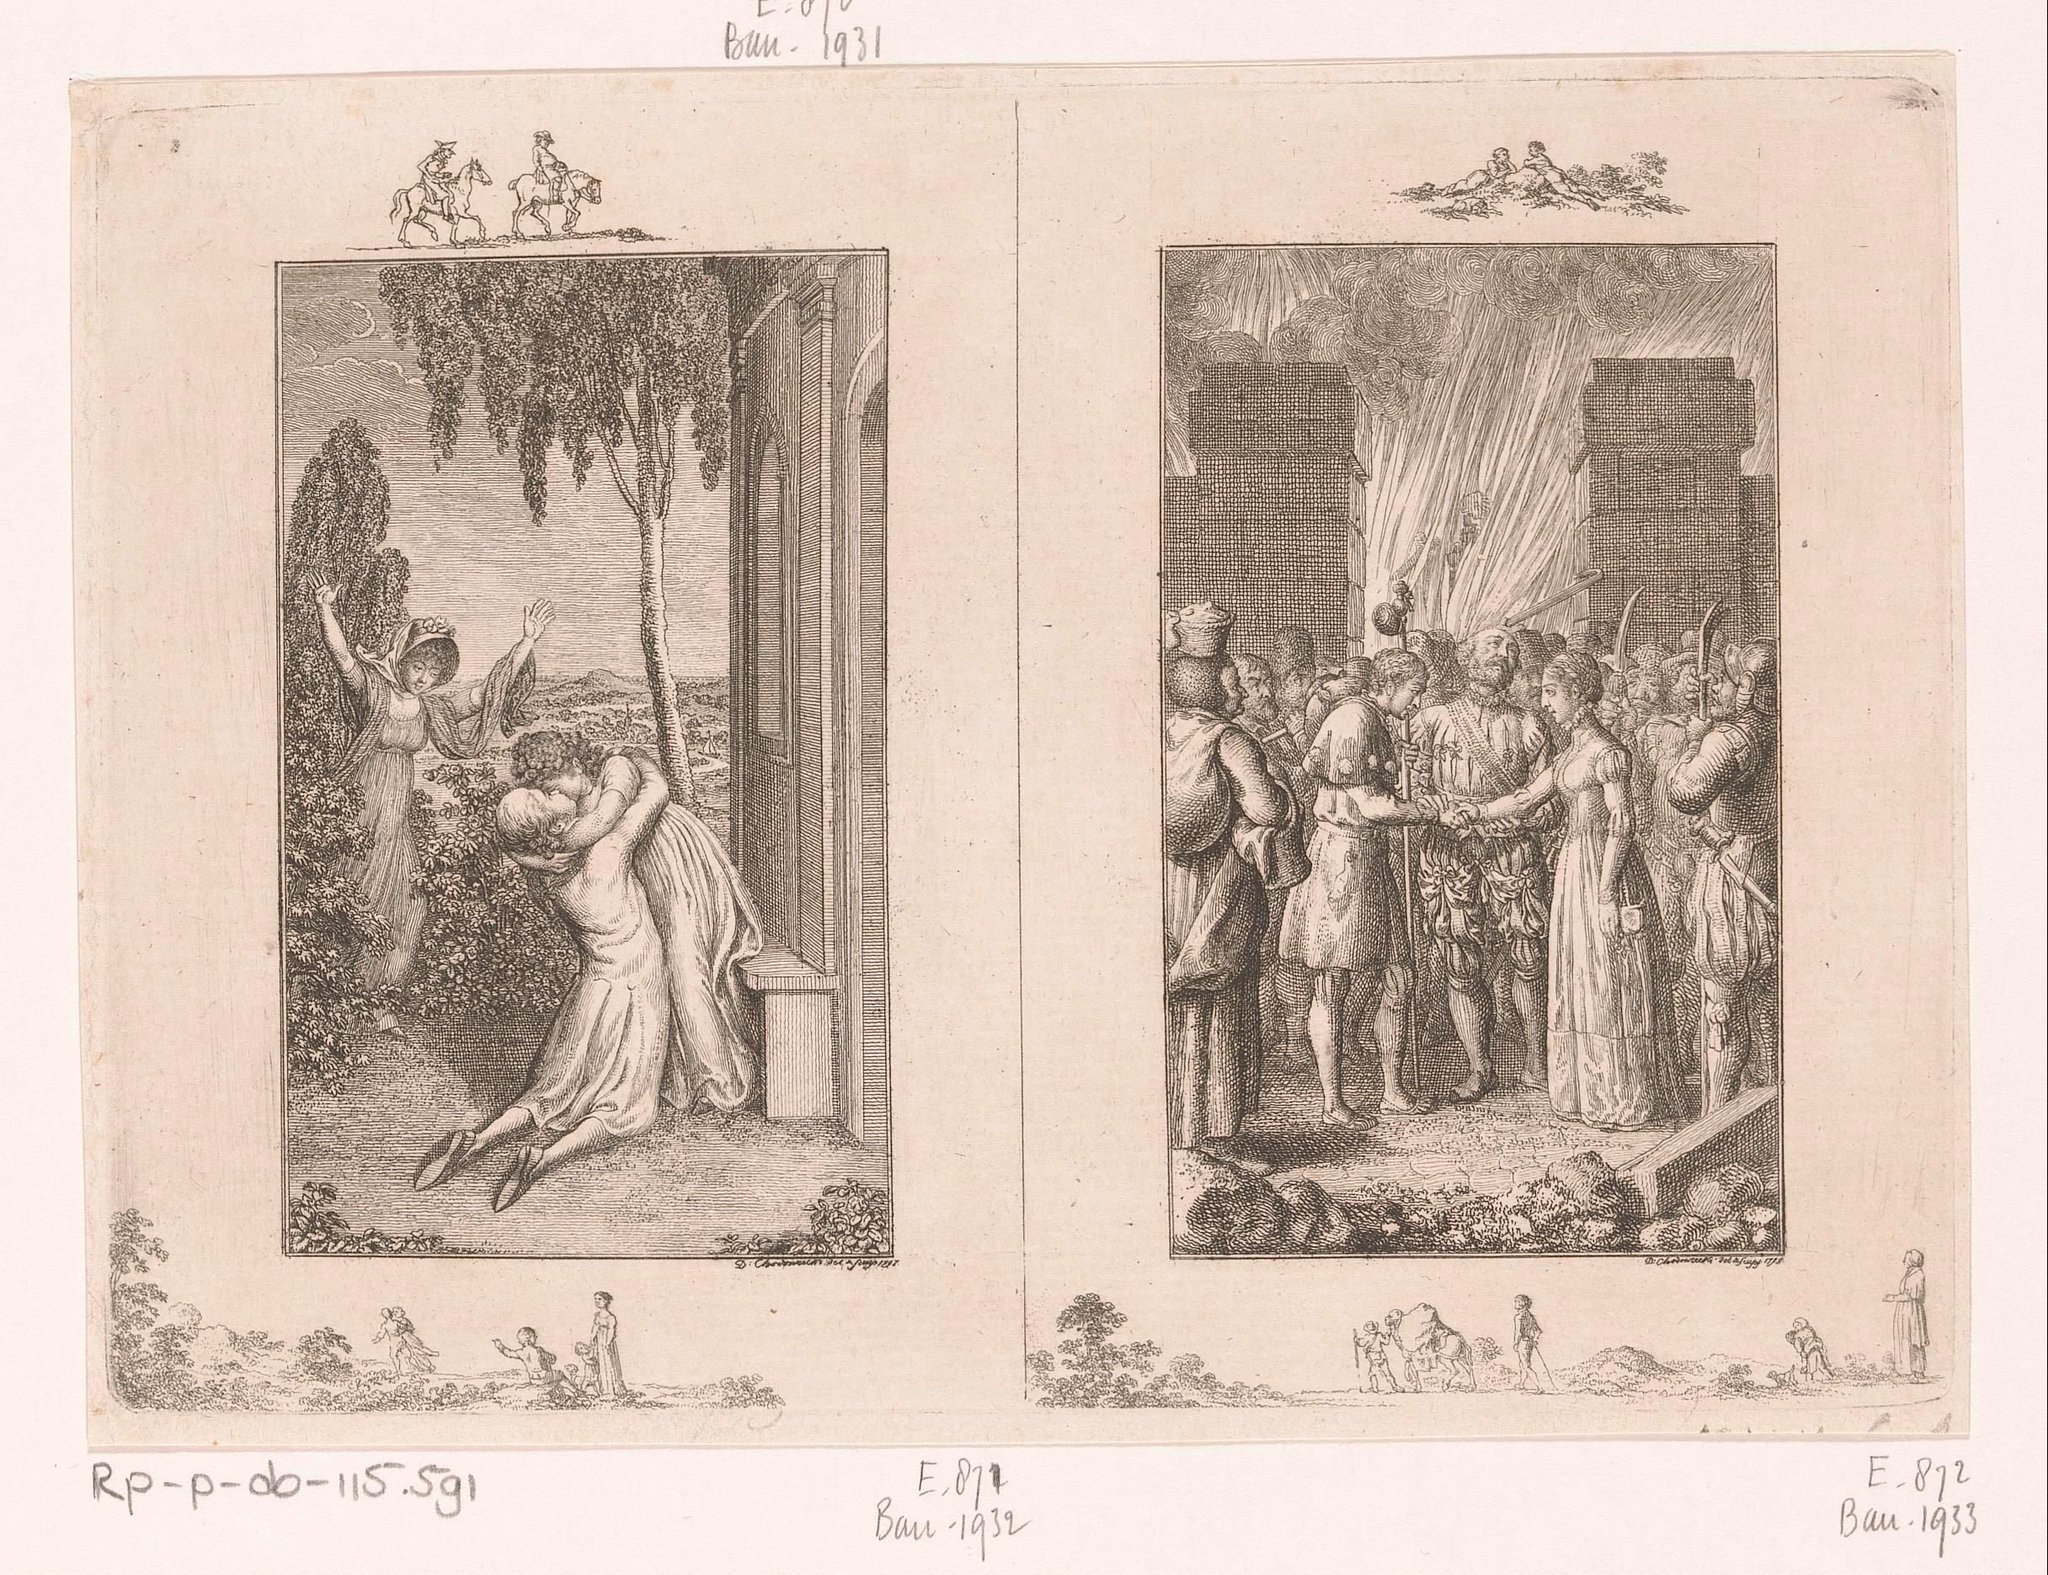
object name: print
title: Twee voorstellingen uit de verhalen van Wilhelm Gottlieb Becker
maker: daniel nikolaus chodowiecki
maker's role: draughtsman, print maker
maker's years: 1726-1801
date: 1797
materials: paper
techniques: etching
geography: berlin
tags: on fire, ablaze, pilgrim(s), kneeling figure, interrupted meeting, lovers caught by surprise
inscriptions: collector's mark: Lugt 2228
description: Latere staat gebruikt voor de verhalen 'Die glückliche Rettung' en 'Adelwold und Emma' in: Becker, Wilhelm Gottlieb. Almanach und Taschenbuch zum geselligen Vergnügen von W. G. Becker für 1799. Leipzig: Voss und Comp., 1798.